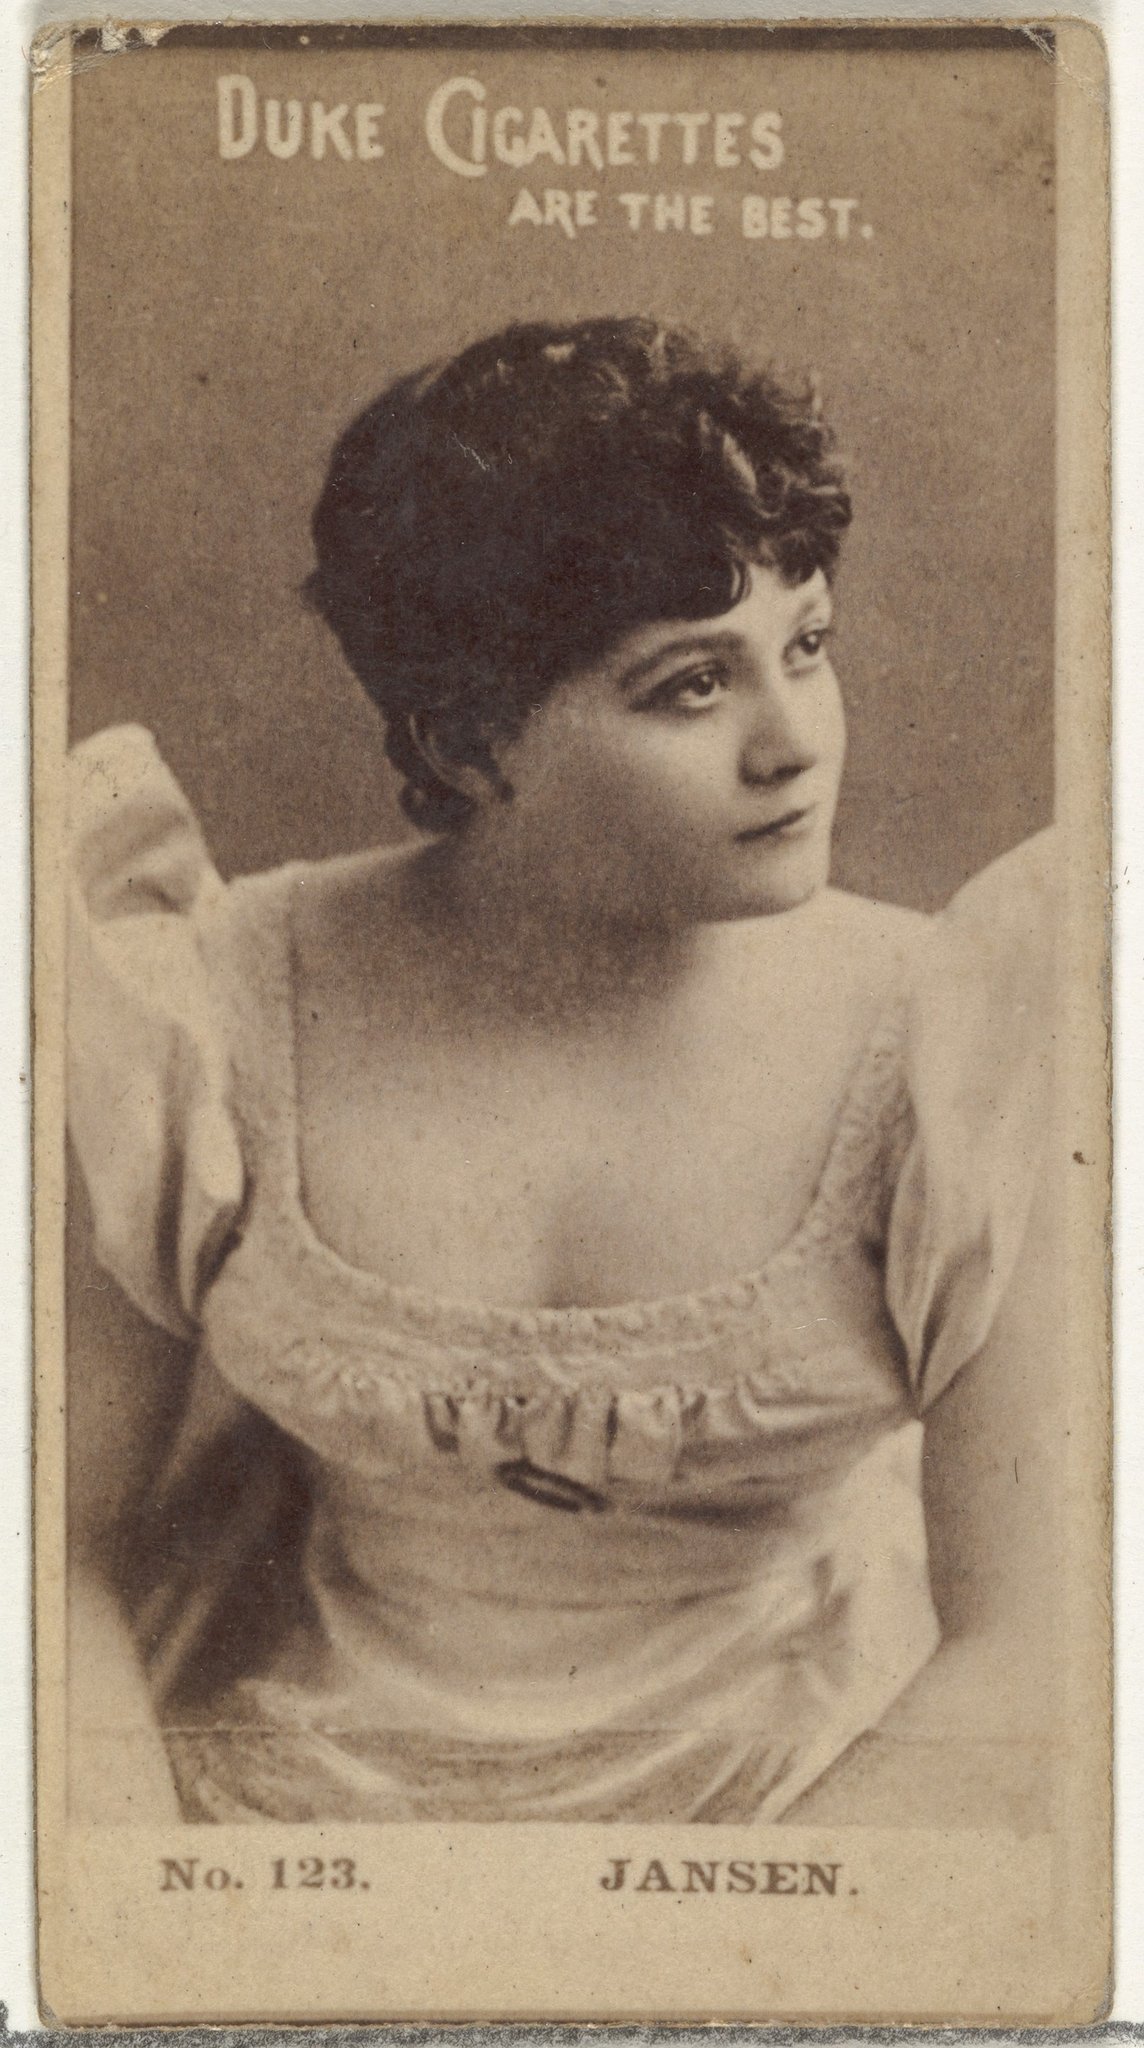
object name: photograph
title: Card Number 123, Jansen, from the Actors and Actresses series (N145-6) issued by Duke Sons & Co. to promote Duke Cigarettes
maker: w. duke, sons & co.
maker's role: publisher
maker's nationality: american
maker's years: 1870-1920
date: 1880-1889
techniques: albumen silver print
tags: portraits,women,actresses